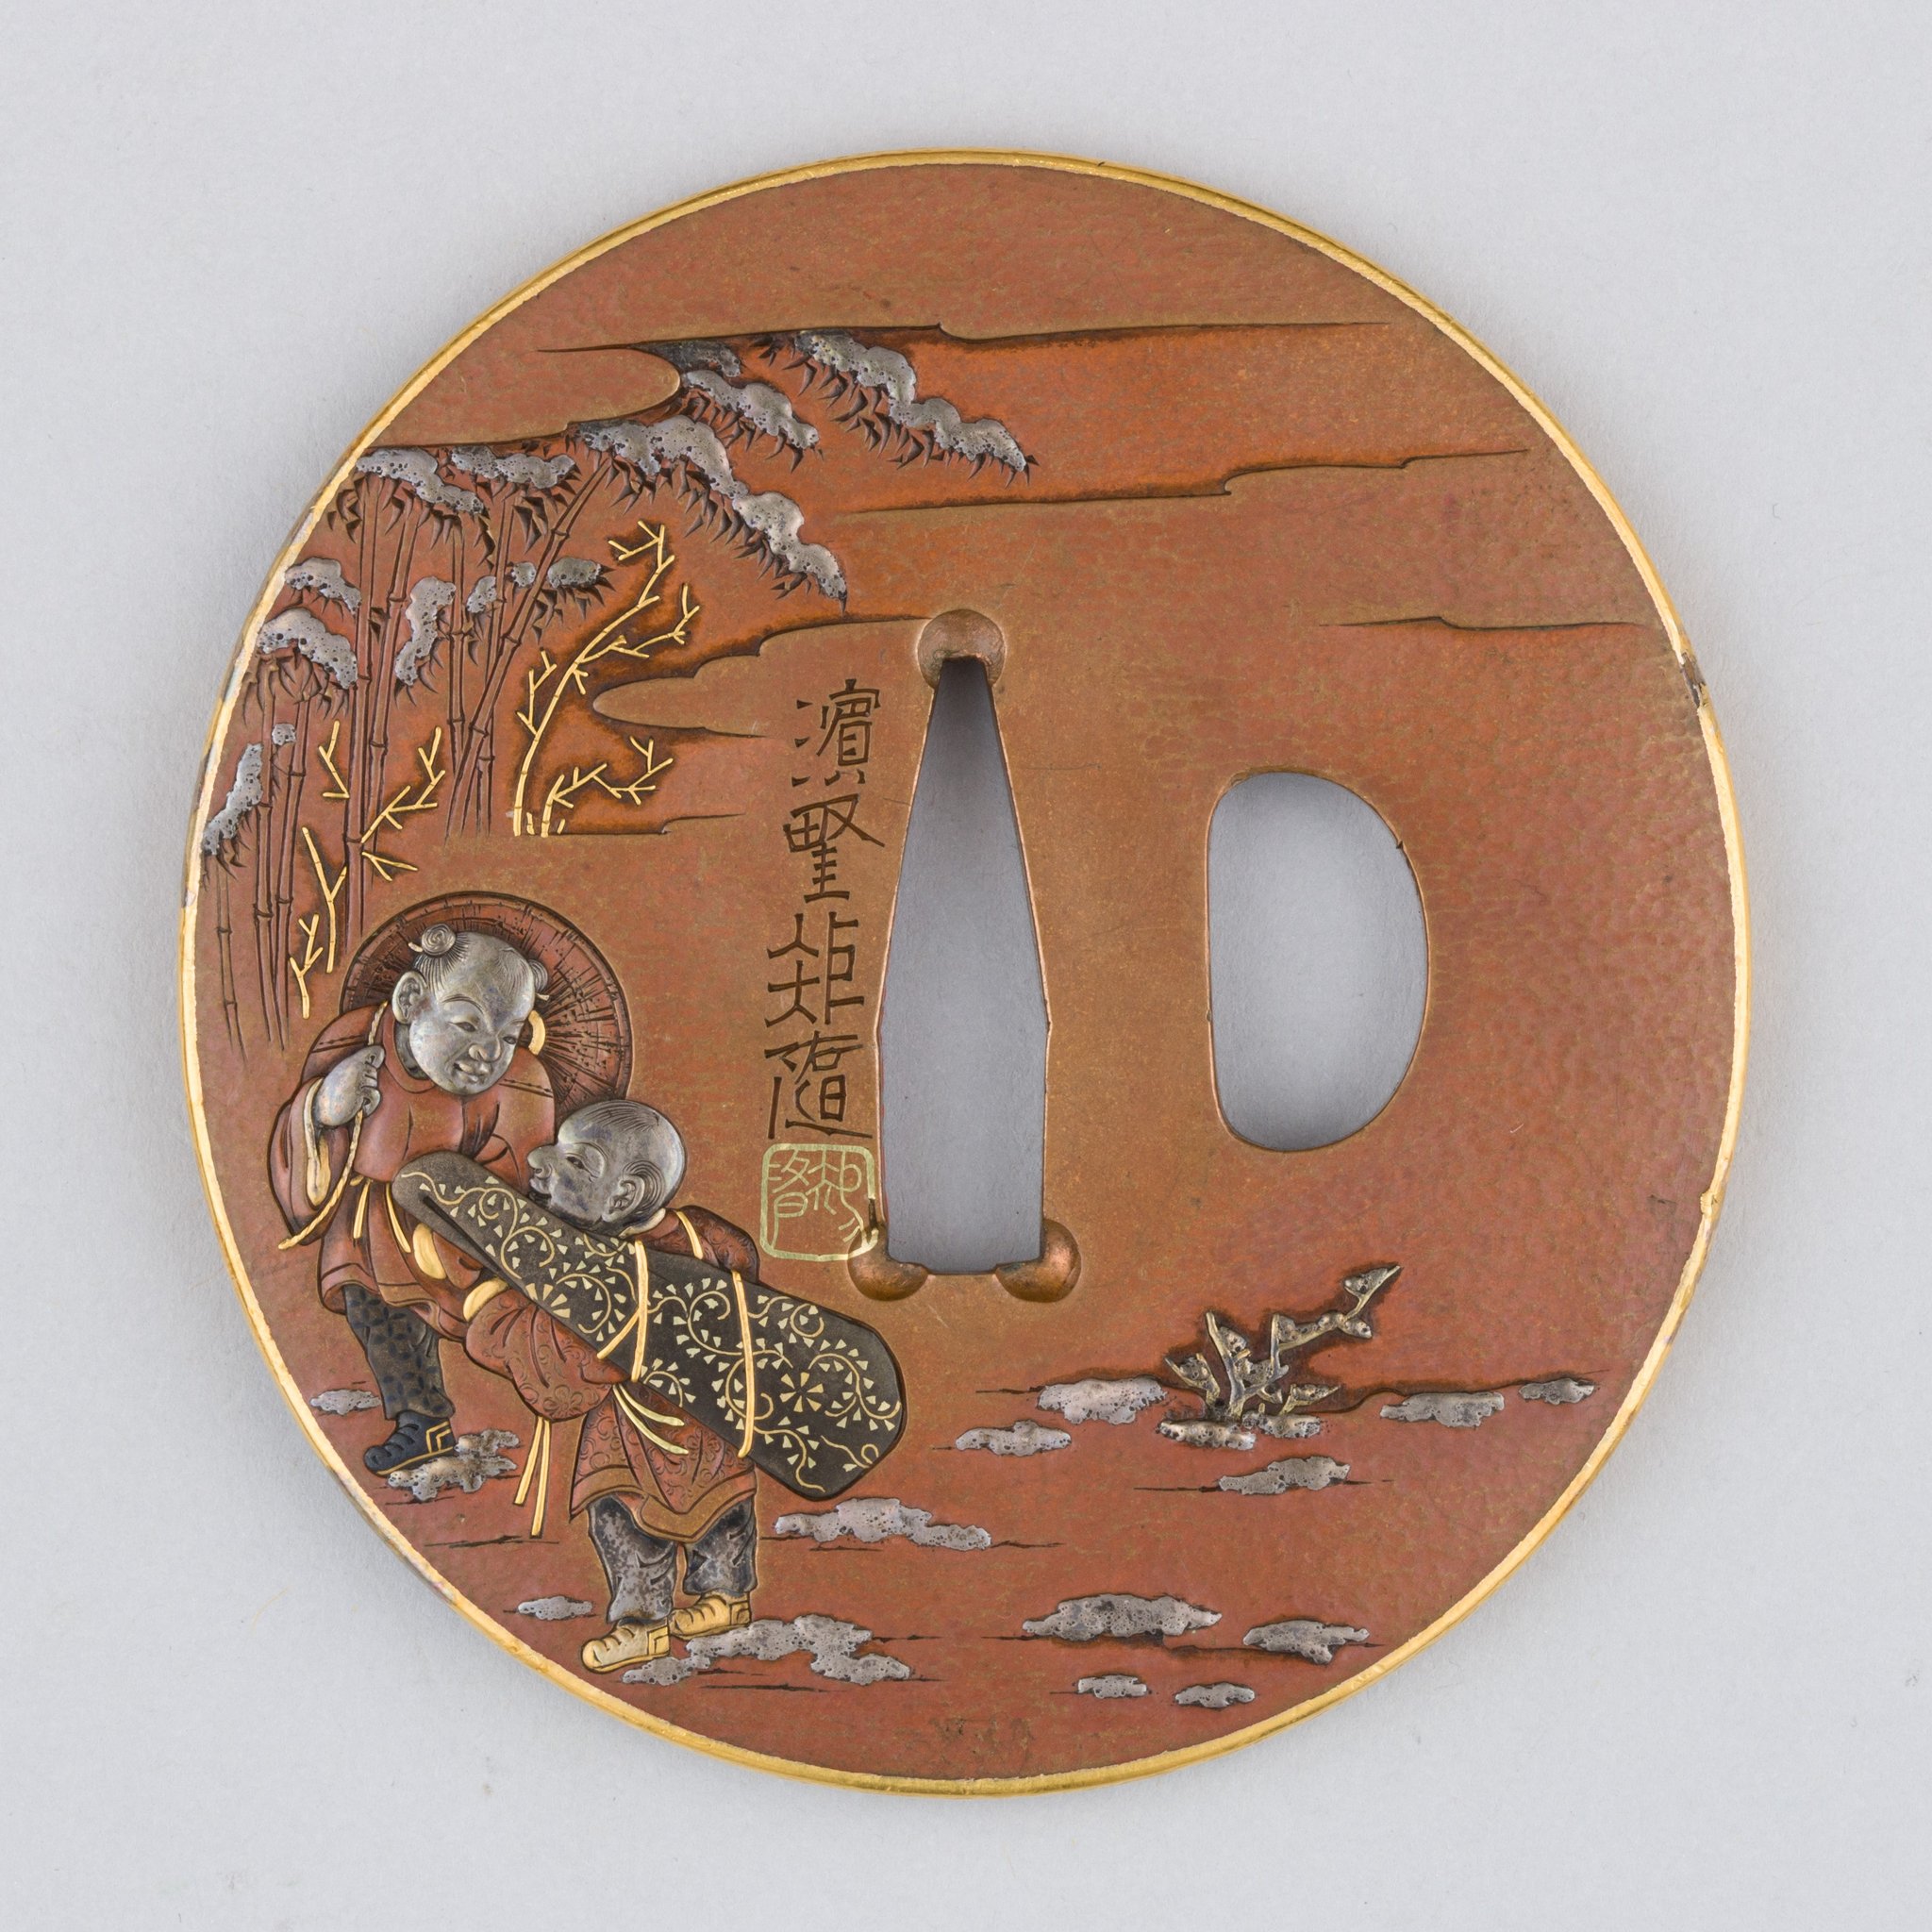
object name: sword guard tsuba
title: Sword Guard (Tsuba)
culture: japanese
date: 1701-1800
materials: copper, gold alloy, gold, silver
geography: japan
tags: men